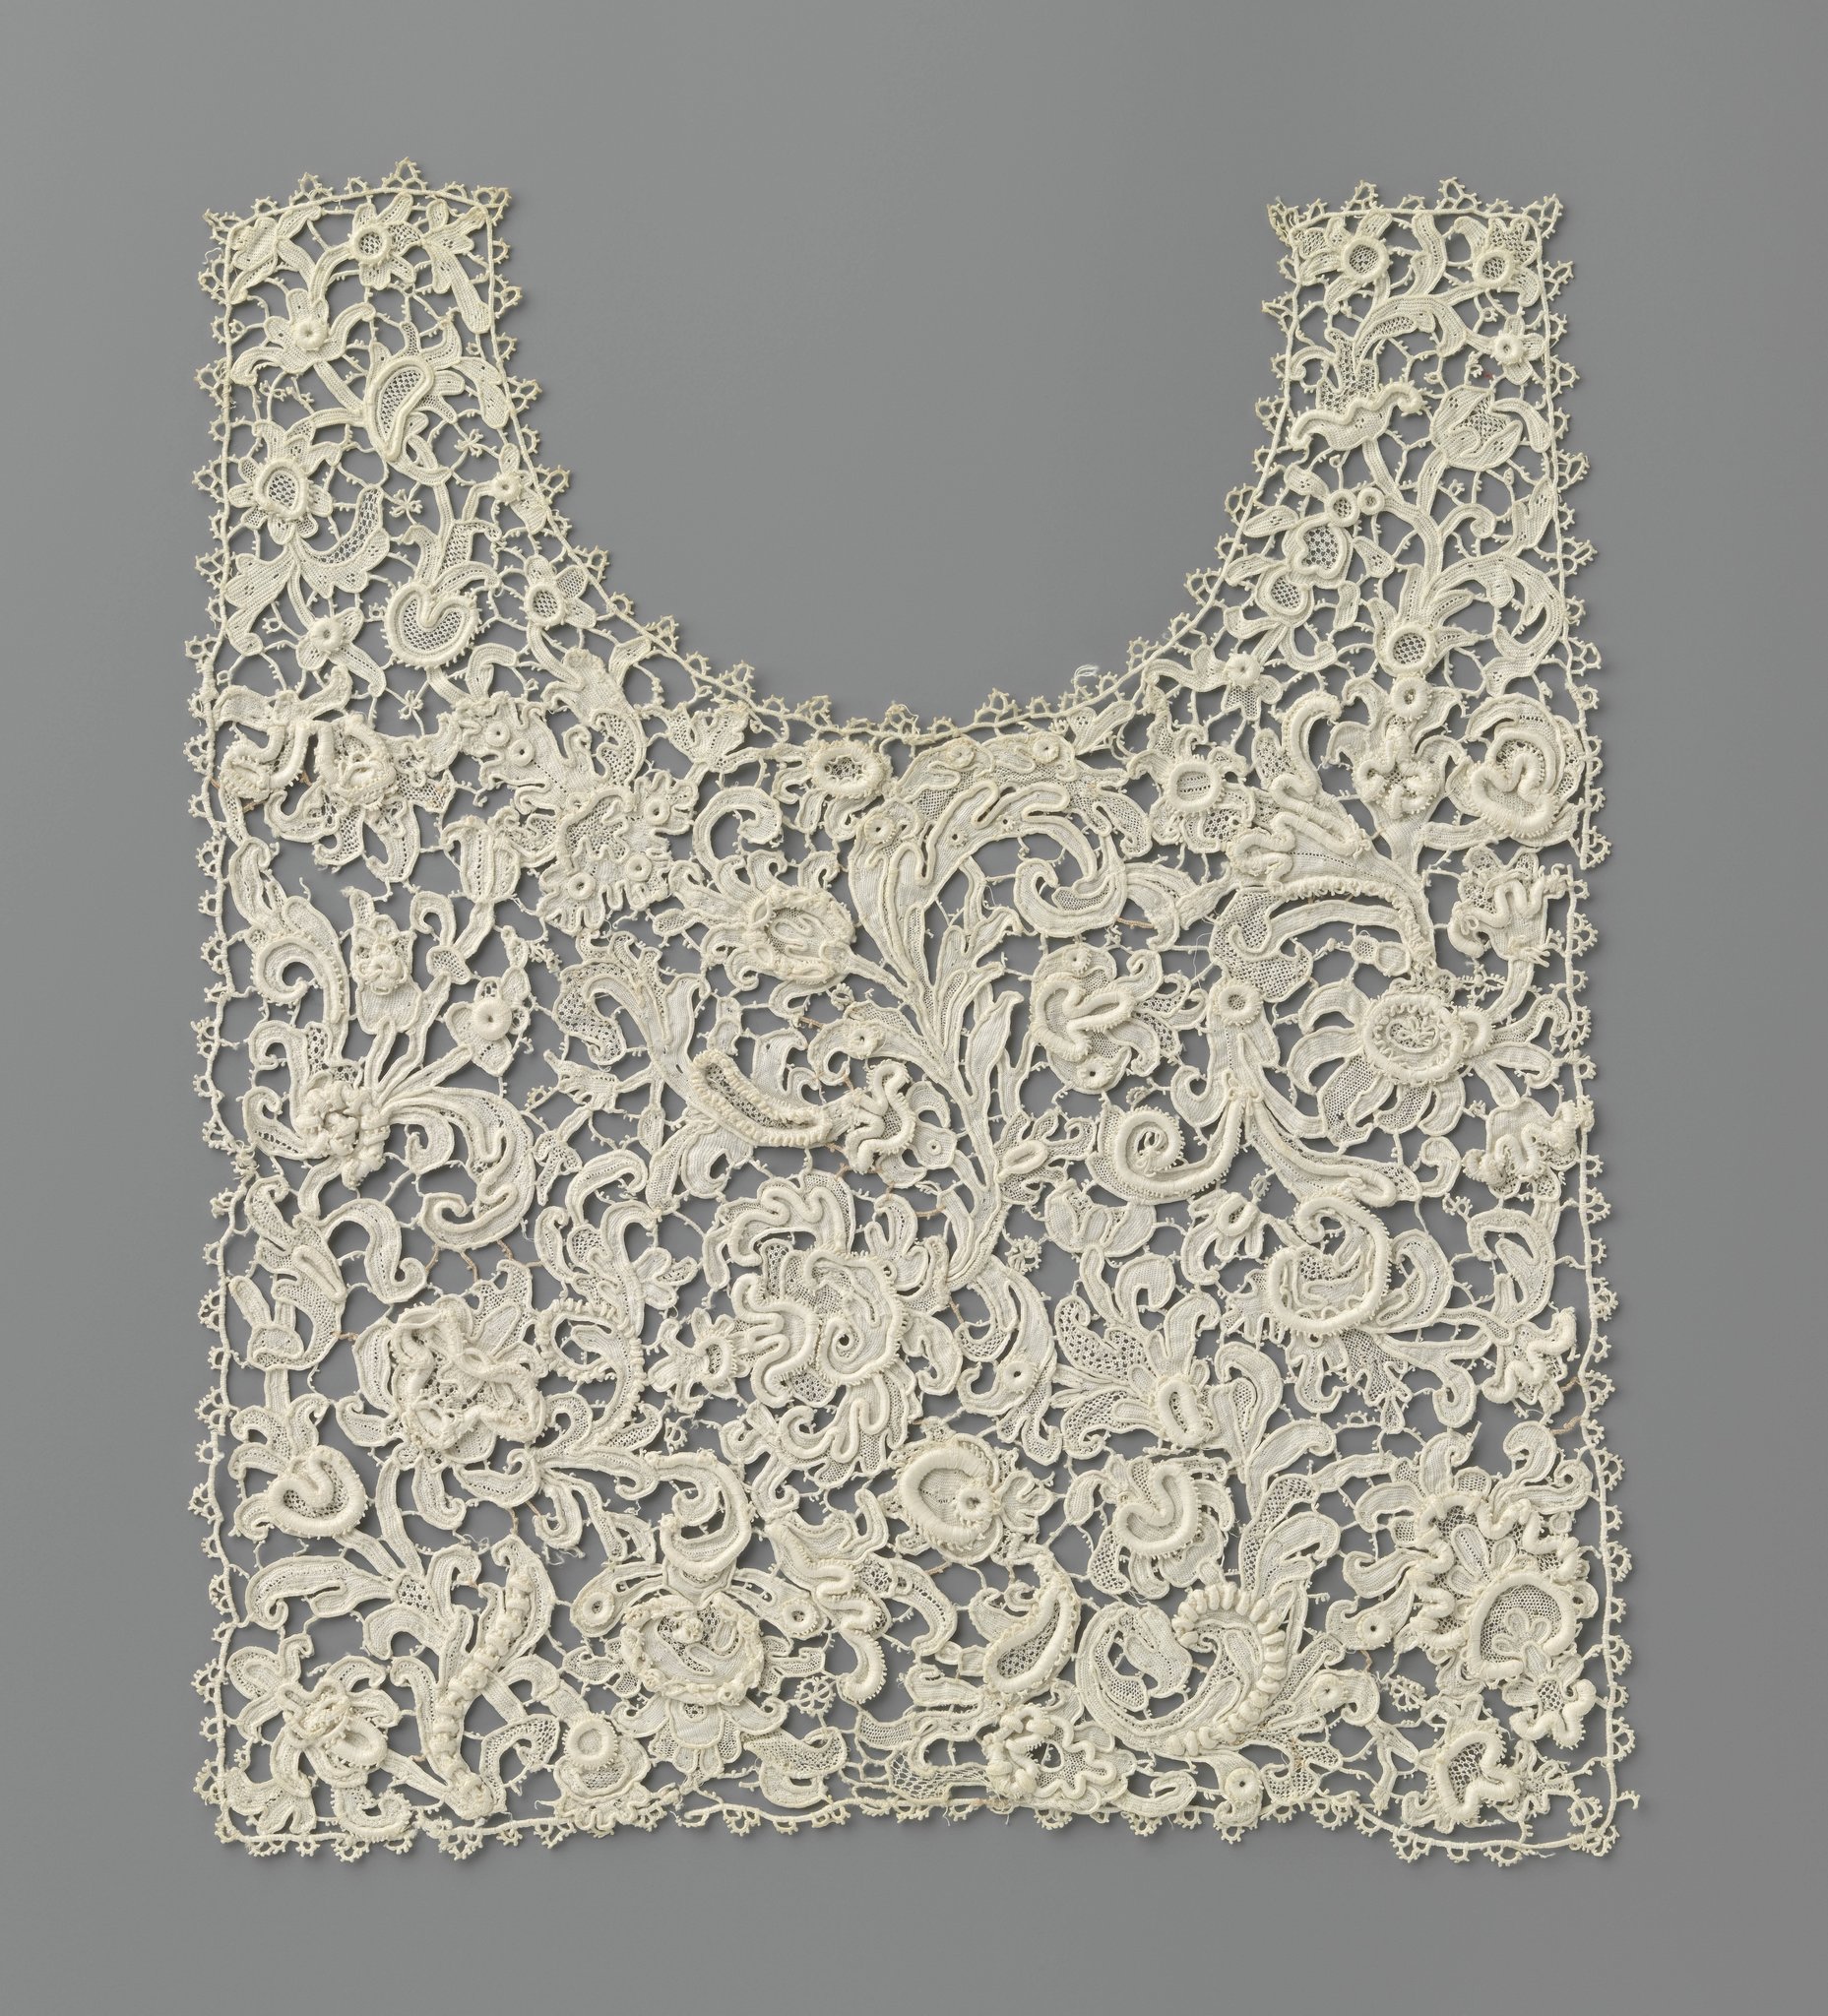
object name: vest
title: Vest of modestie van naaldkant met diep ingesneden kroonbladeren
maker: Anonymous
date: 1800-1899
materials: linen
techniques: embroidery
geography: burano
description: Vest of modestie van naturelkleurige naaldkant: Venetiaanse reliëfkant. Uit een rechthoek is een halfronde halsvorm uitgespaard. Fijne en zeer vertakte ranken dragen gevederde bladvoluten en palmetbloemen met diep ingesneden kroonbladeren. Vele reliëfs zijn nog door dwarse C-vormige reliëfjes aangedikt. Spijlengrond.